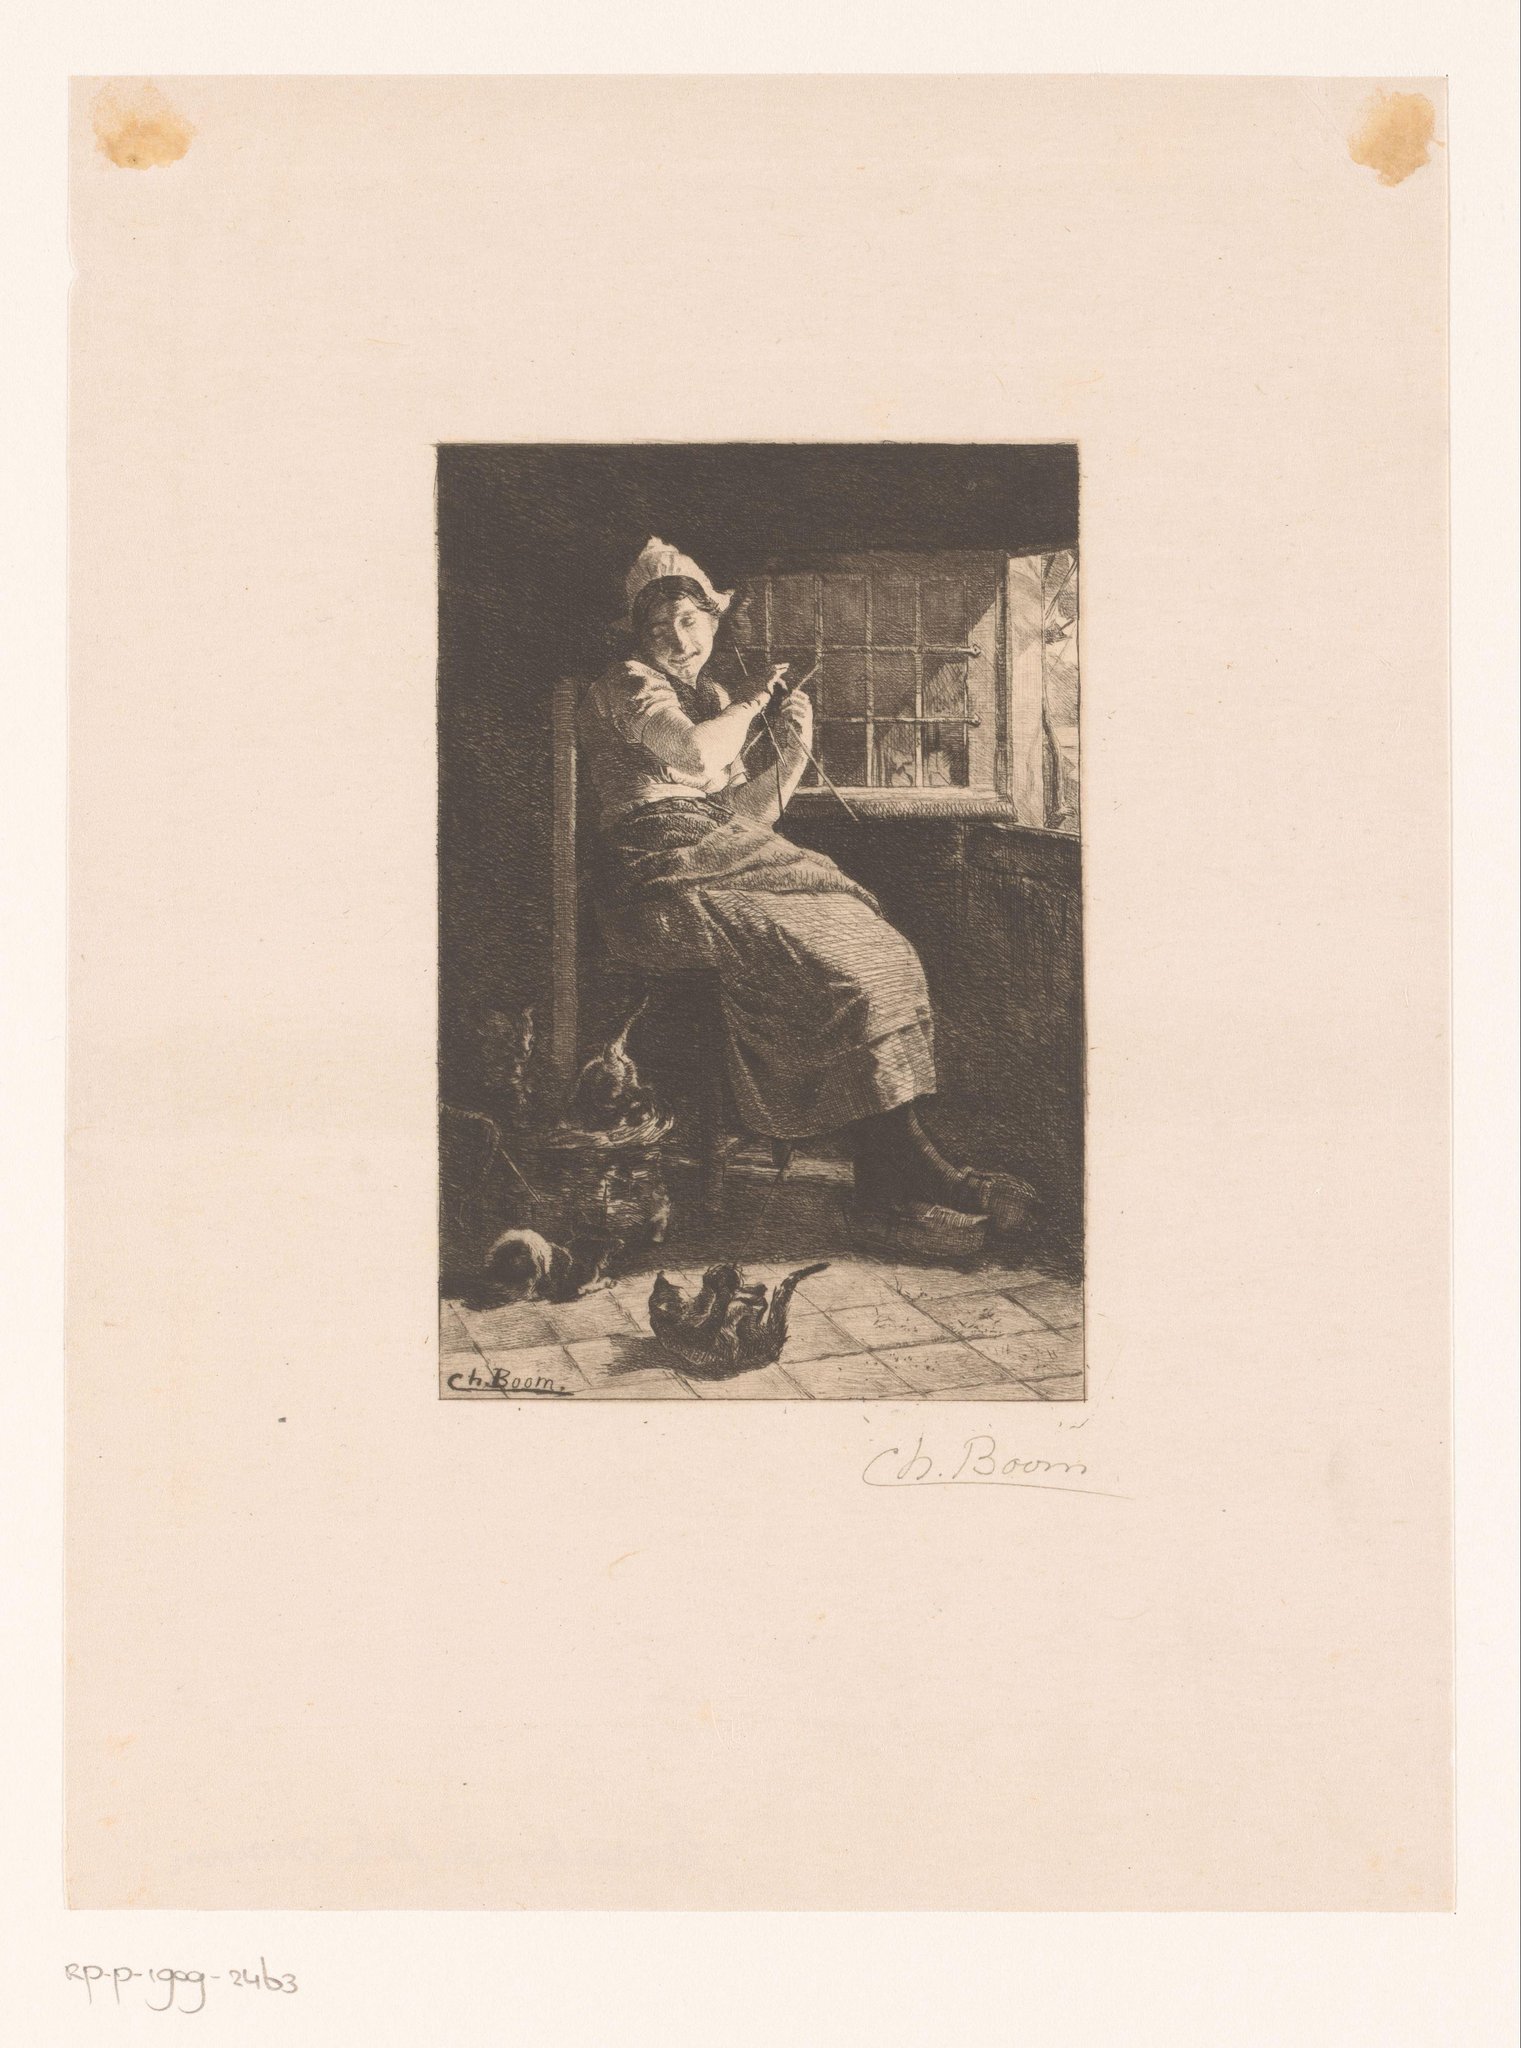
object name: print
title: Les intimes de la maison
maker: charles boom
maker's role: print maker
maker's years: 1858-1939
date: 1888-1889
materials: paper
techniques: etching, intaglio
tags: cat, knitting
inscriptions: mark: ‘Antwerpsche Etsers 1880’, collector's mark: Lugt 2228